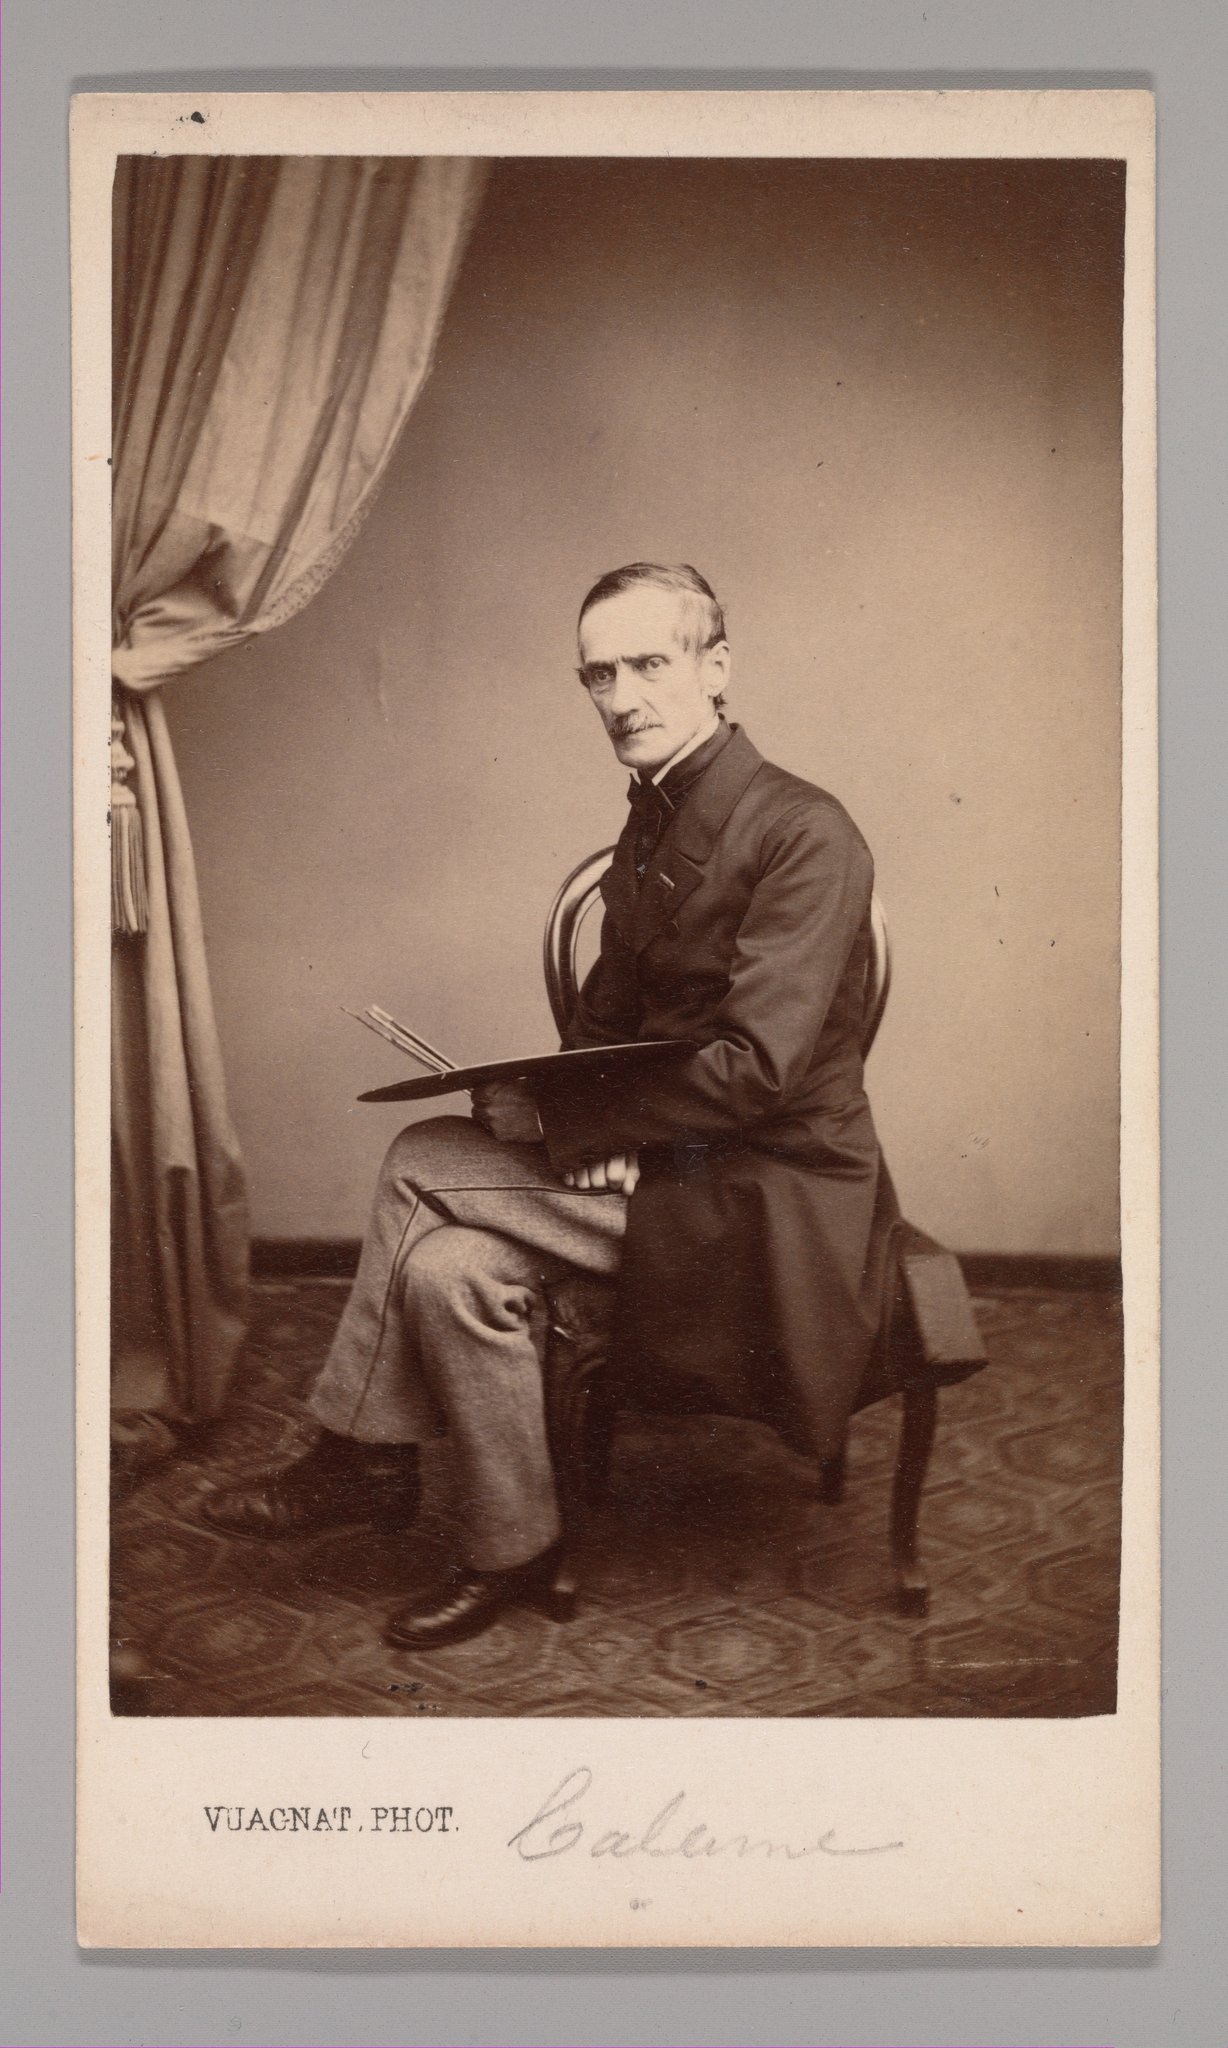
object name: carte de visite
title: [Alexander Calame]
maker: vuagnat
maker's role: artist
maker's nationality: swiss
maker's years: 1859-1870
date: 1860-1869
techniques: albumen silver print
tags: men,portraits